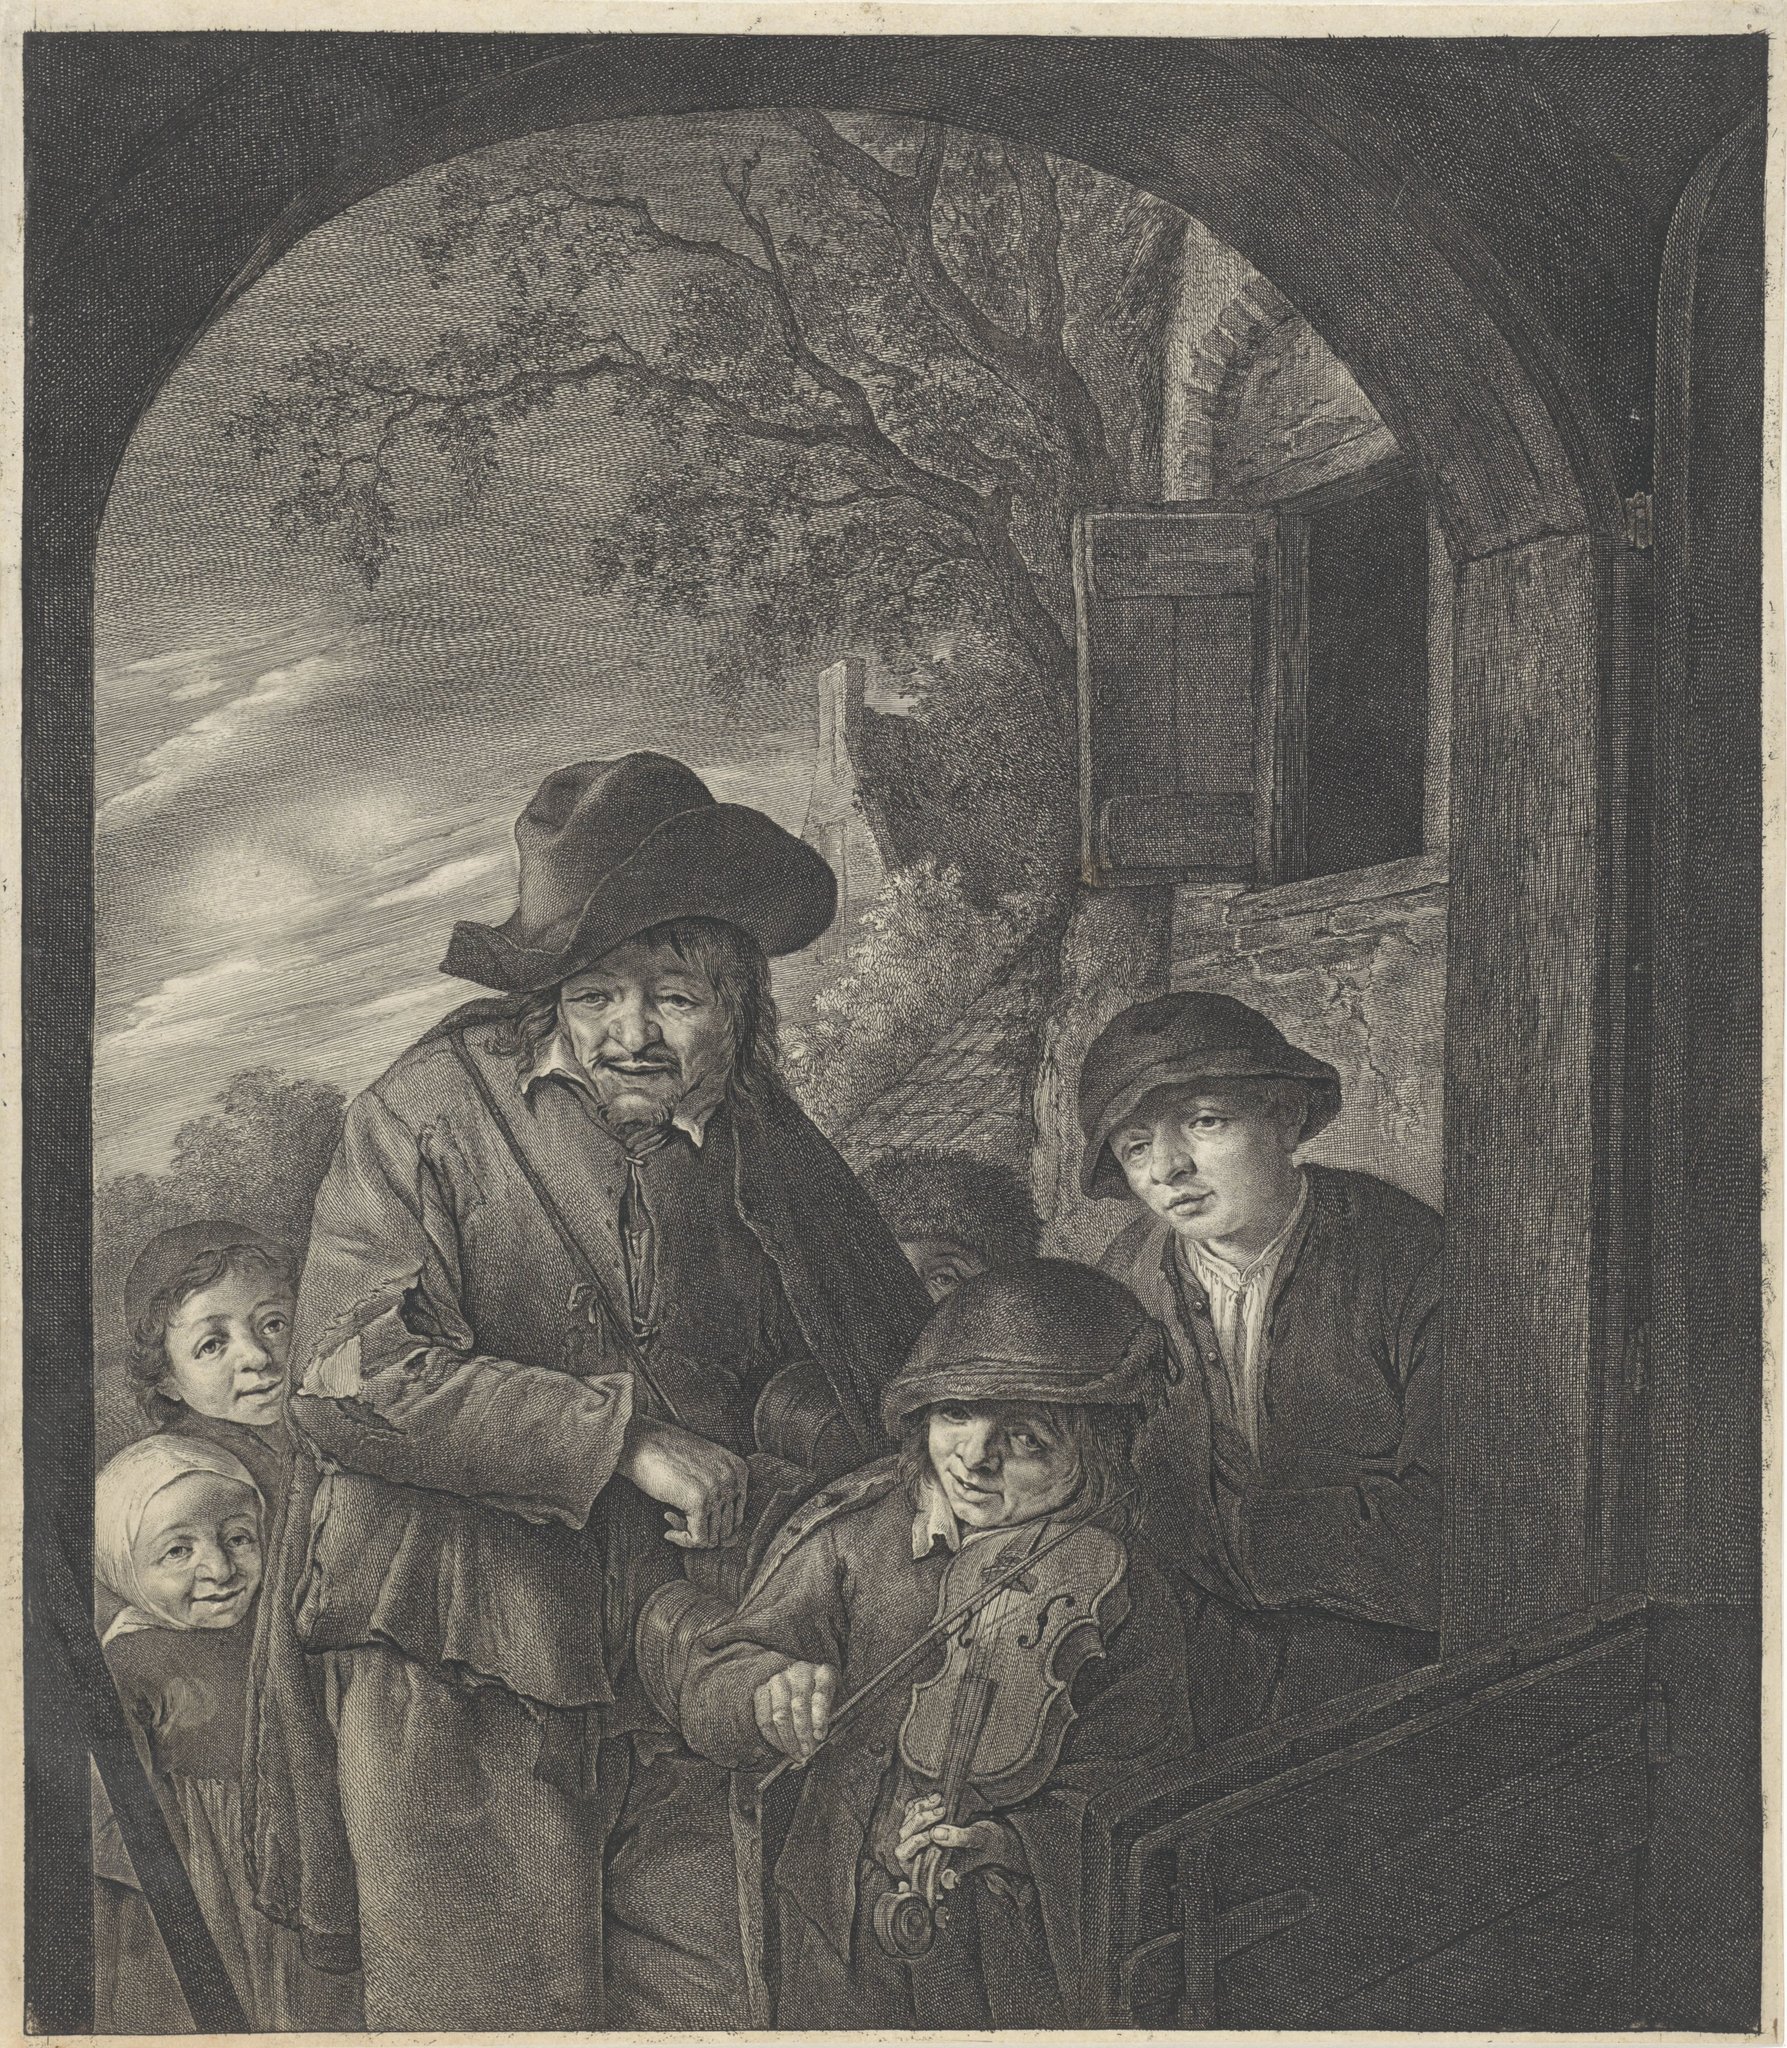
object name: print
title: Liereman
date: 1638-1658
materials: paper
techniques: engraving, etching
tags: making music; musician with instrument, violin, fiddle, hurdy-gurdy player, beggar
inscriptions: collector's mark: Lugt 11, collector's mark: Lugt 10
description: Een bedelaarsfamilie musiceert bij een deuropening. Een jongen speelt viool en een man met gescheurde kleding laat zijn draailier horen. De rest van de kinderen staan er omheen.